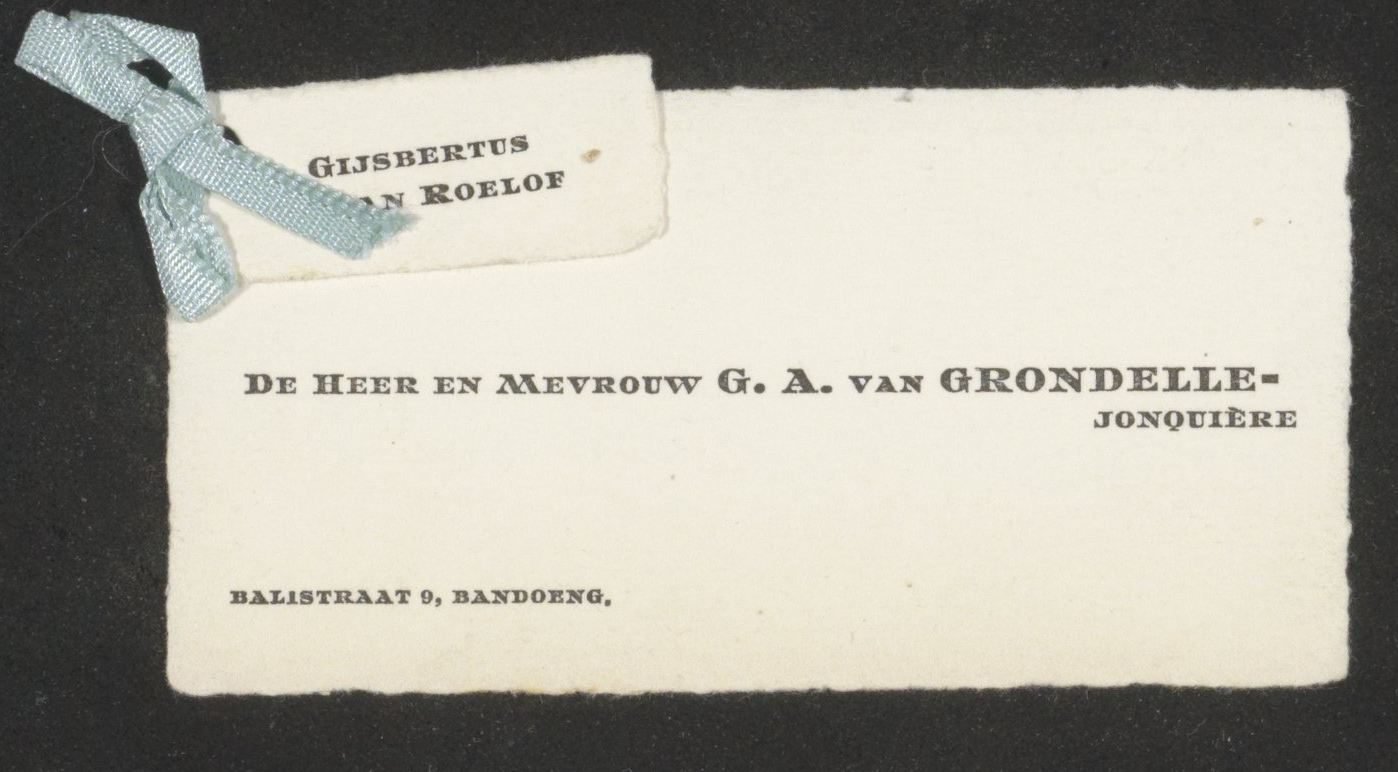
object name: birth announcement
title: Geboortekaart van Gijsbertus Johan Roelof, zoon van de heer en mevrouw G.A. van Grondelle-Jonquière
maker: Anonymous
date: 1930-1949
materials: paper, textile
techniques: printing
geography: bandung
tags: further education (+ pupil), further education, confinement, birth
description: Onderdeel van Stamboek van de leerlingen der Koloniale School voor Meisjes en Vrouwen te 's-Gravenhage deel II (1930-1949).